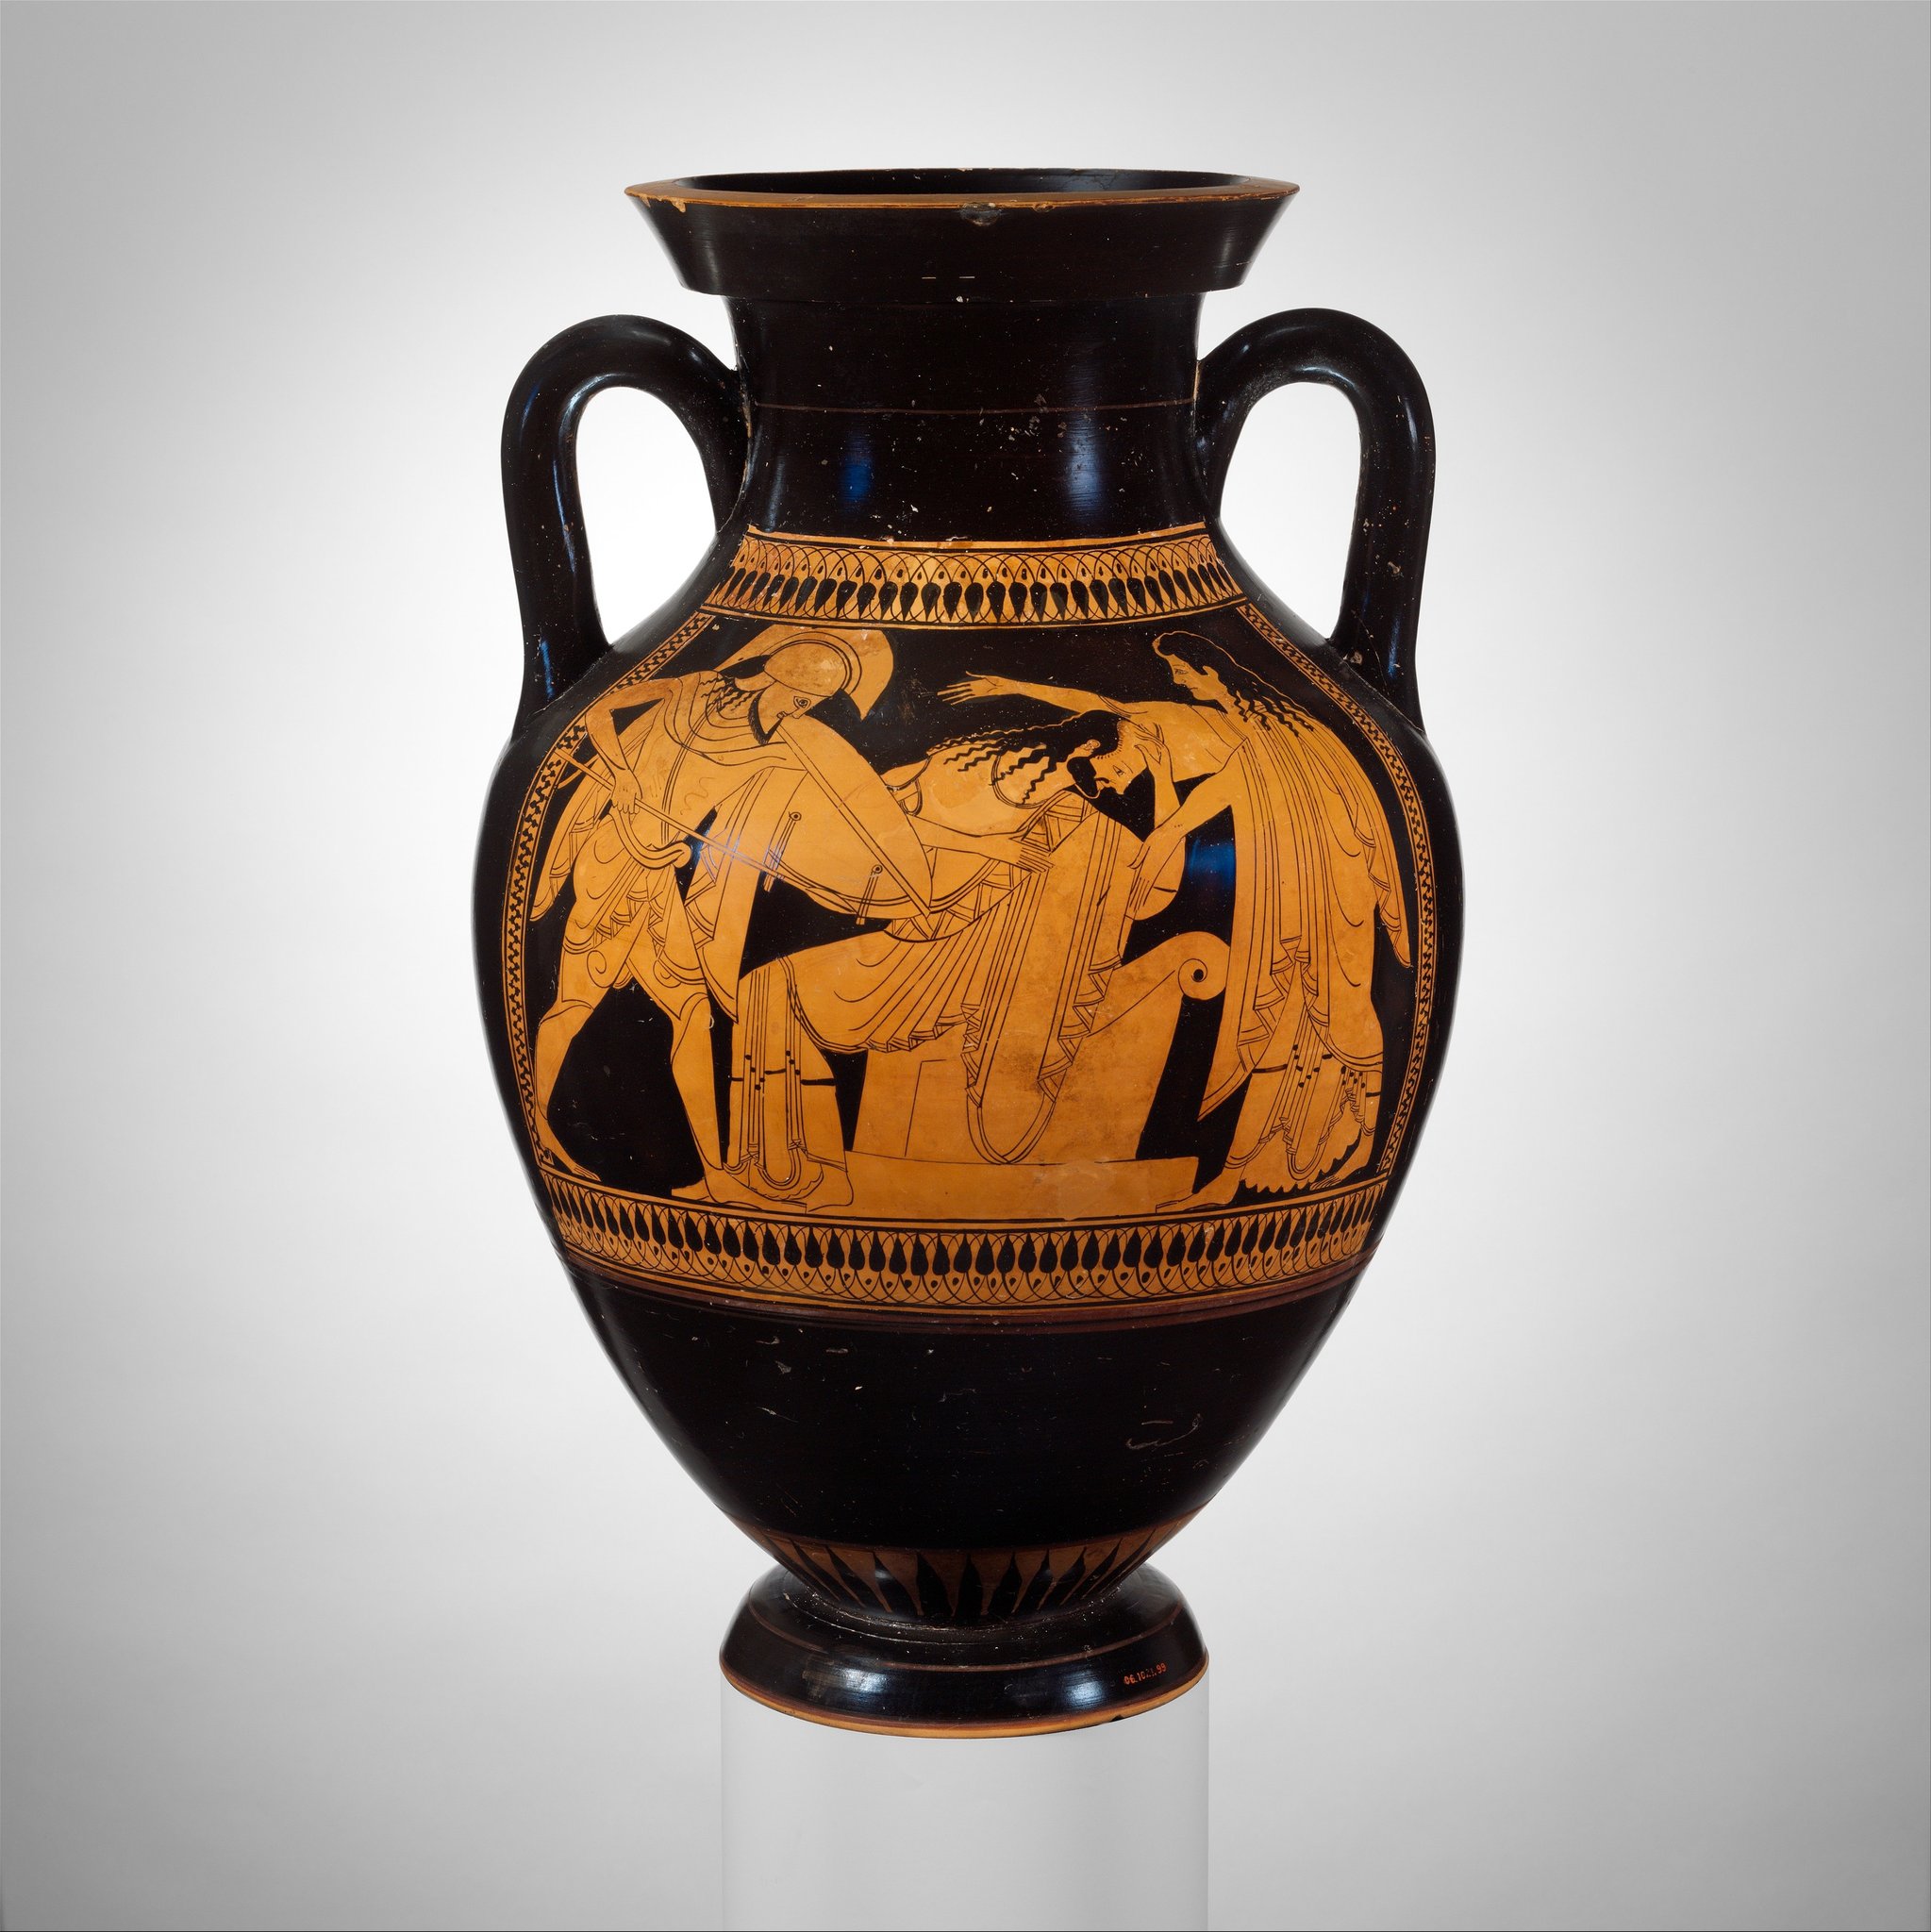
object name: amphora, type b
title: Terracotta amphora (jar)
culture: greek, attic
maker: nikoxenos painter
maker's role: artist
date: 500 BCE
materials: terracotta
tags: altars,spears